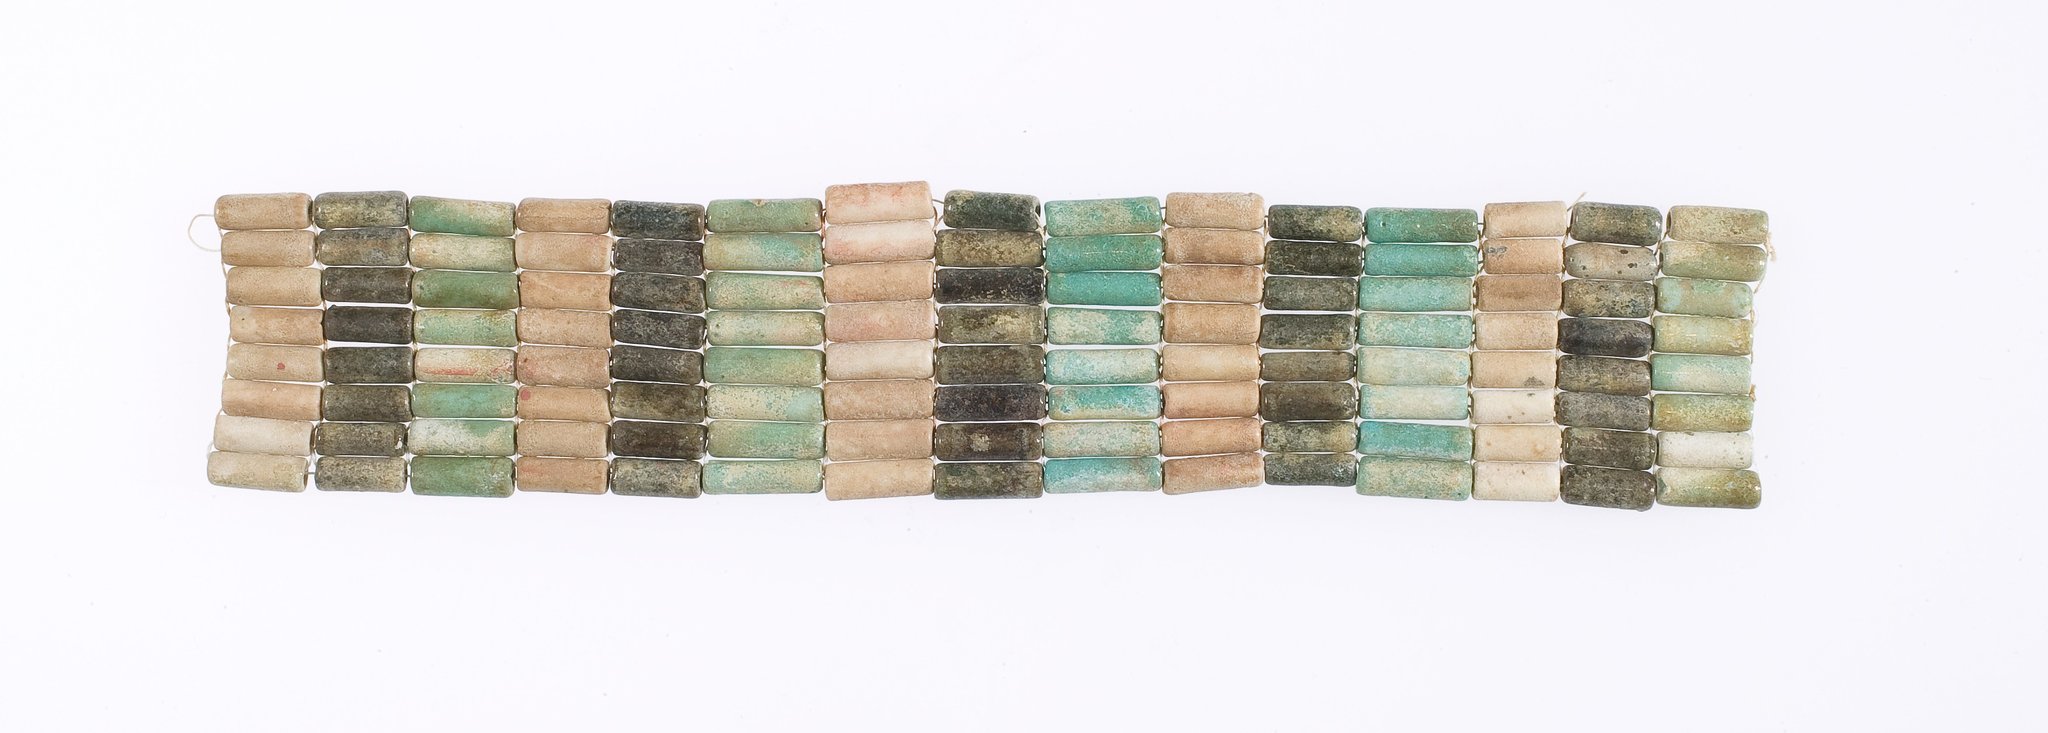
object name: bracelet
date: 1802-1700 BCE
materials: faience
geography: egypt